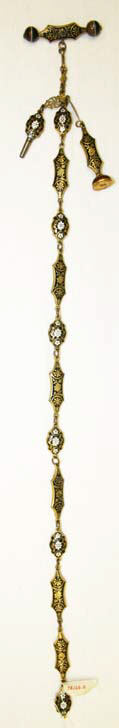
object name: fob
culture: french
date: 1840-1850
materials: enamel, metal